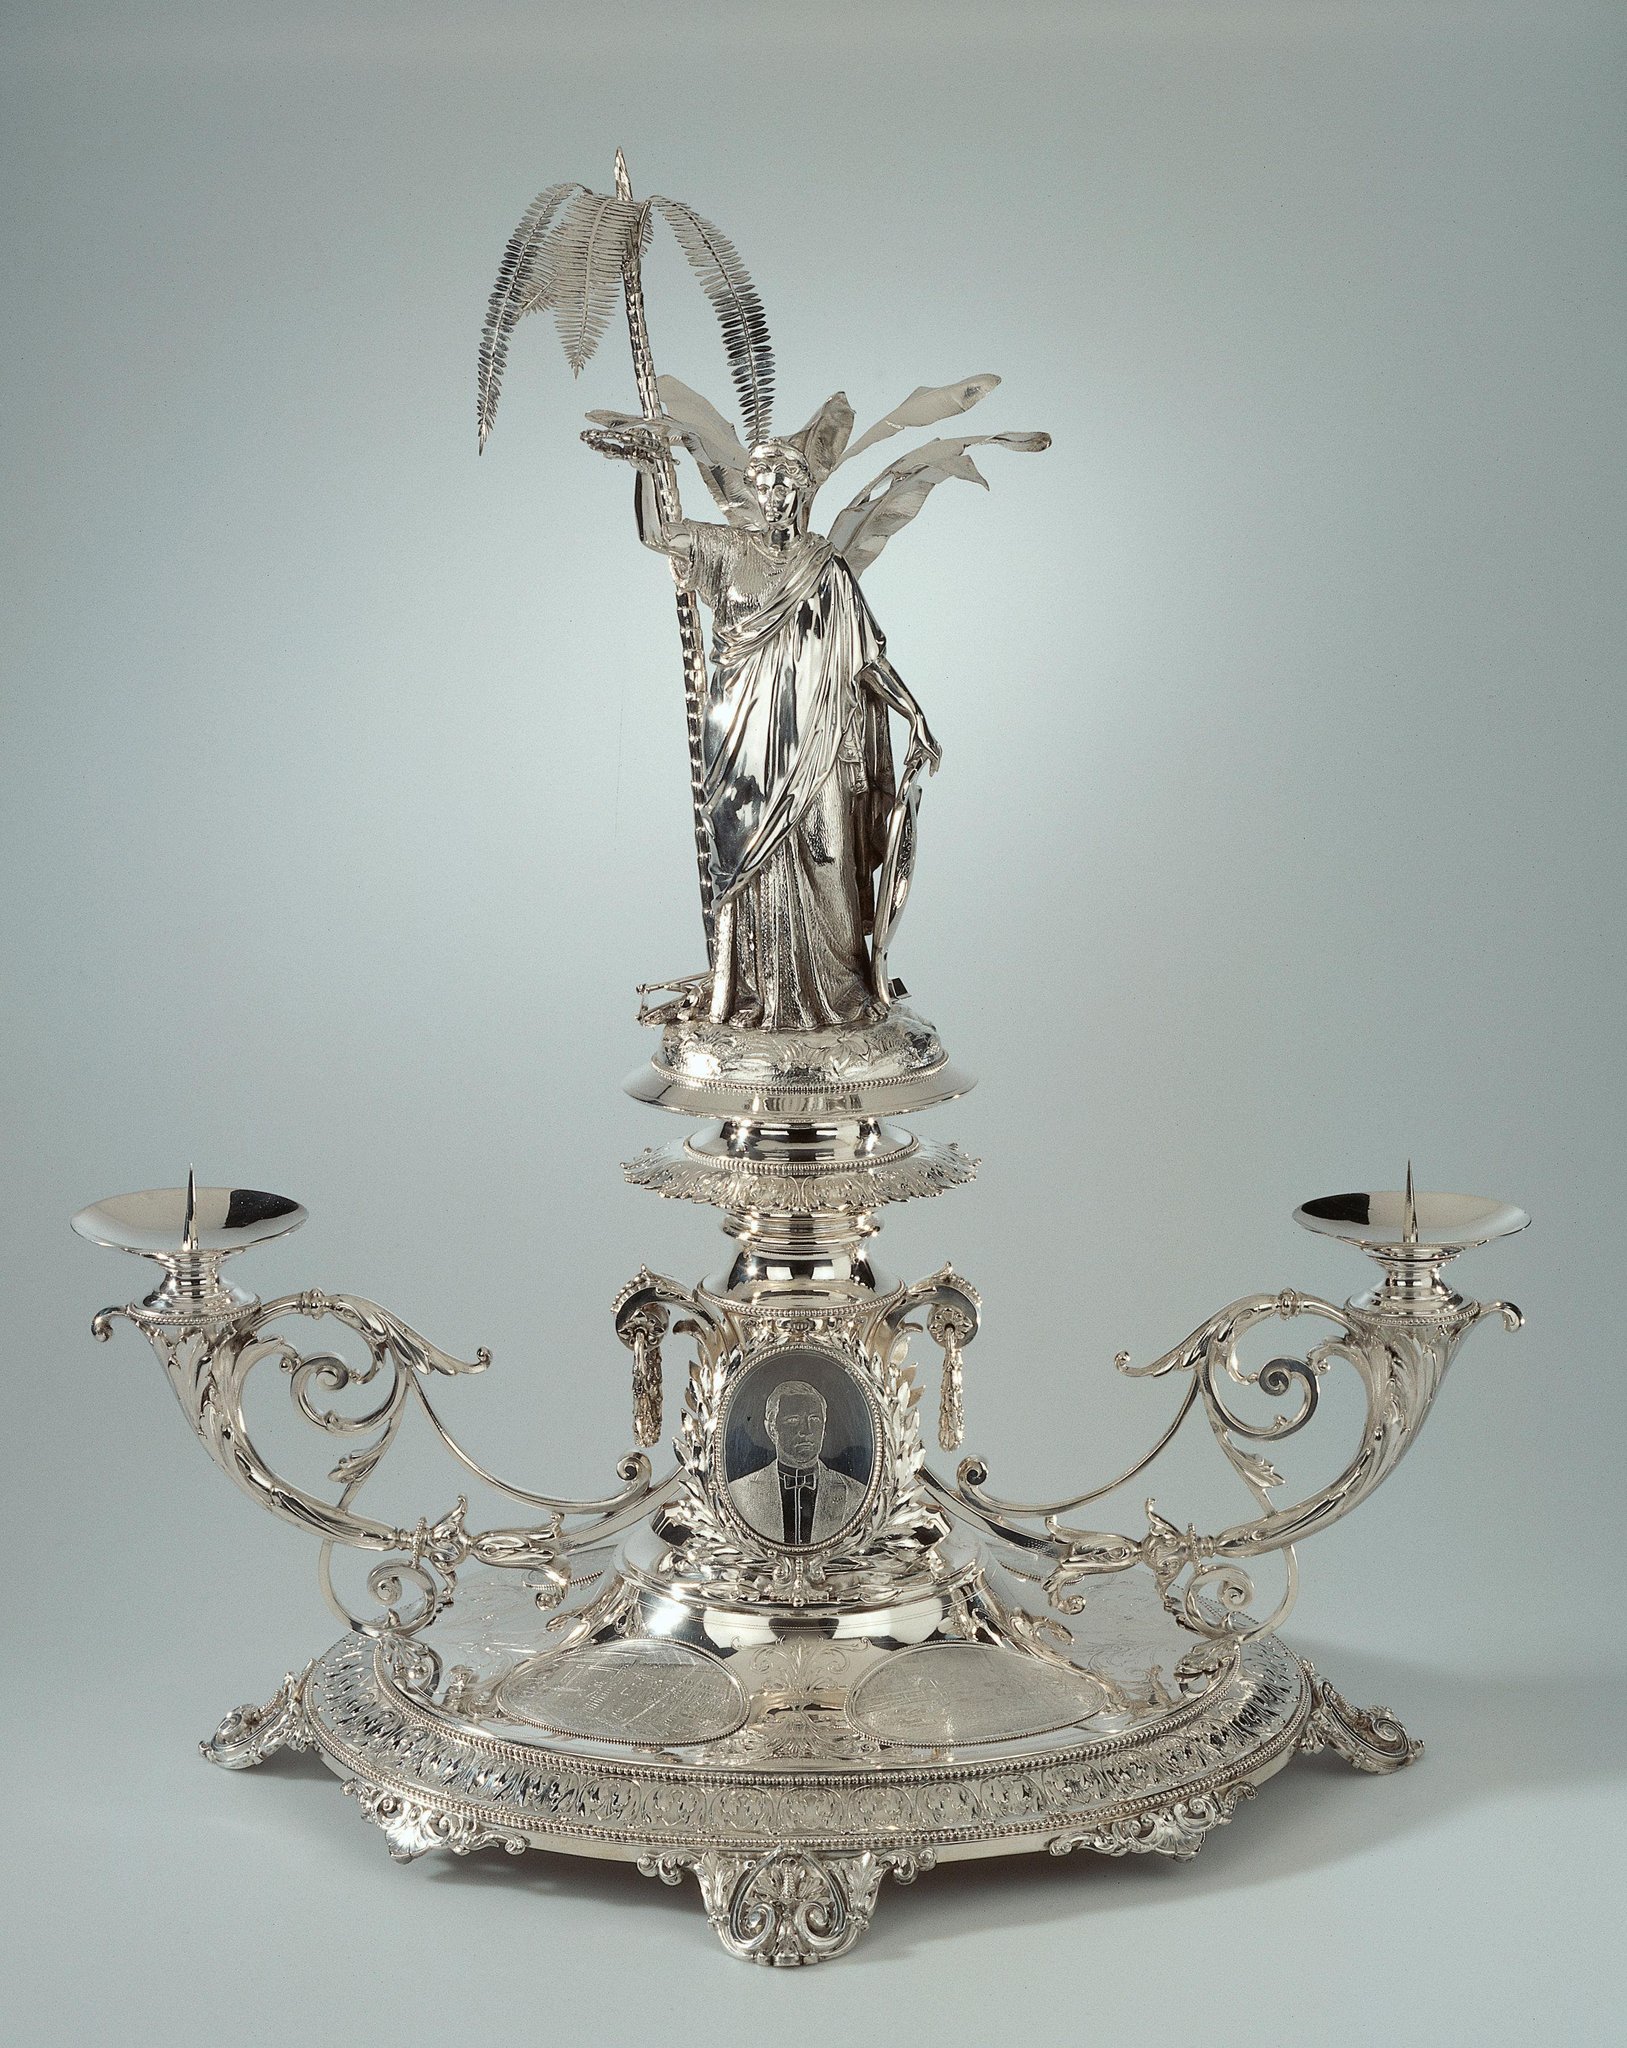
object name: part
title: Onderdeel Pièce de milieu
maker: johannes mattheus van kempen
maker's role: silversmith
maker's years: 1814-1877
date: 1900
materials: silver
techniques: engraving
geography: voorschoten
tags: dutch east indies, the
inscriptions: mark, inscription: ‘Beambten en mijnwerkers der Billiton maatschappij aan hunnen hooggeachte chef J.Ph. Ermeling ter gelegenheid van zijn 70ste verjaardag 21 januari 1901.’, date letter: ‘q’, mark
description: Palmtakken van het bovenstuk van het tafelstuk voorstellende een vrouw met o.a. schild en lauwerkrans (Sri-Billiton) en attributen ontleend aan het werk in de tinmijnen. Rondom het voetstuk 4 medaillons met voorstellingen van de arbeid in de tinmijnen (naar foto's). Op het voetstuk een medaillon met tekst en één met het gegraveerde portret van Ermeling. Bovenaan achter de vrouw twee palmen; aan beide zijden van het voetstuk een kaarsenarm. Tafelstuk is aangeboden door beambten en mijnwerkers van de Billiton Maatschappij aan hun chef J.Ph. Ermeling bij zijn 70ste verjaardag op een feest op Billiton.